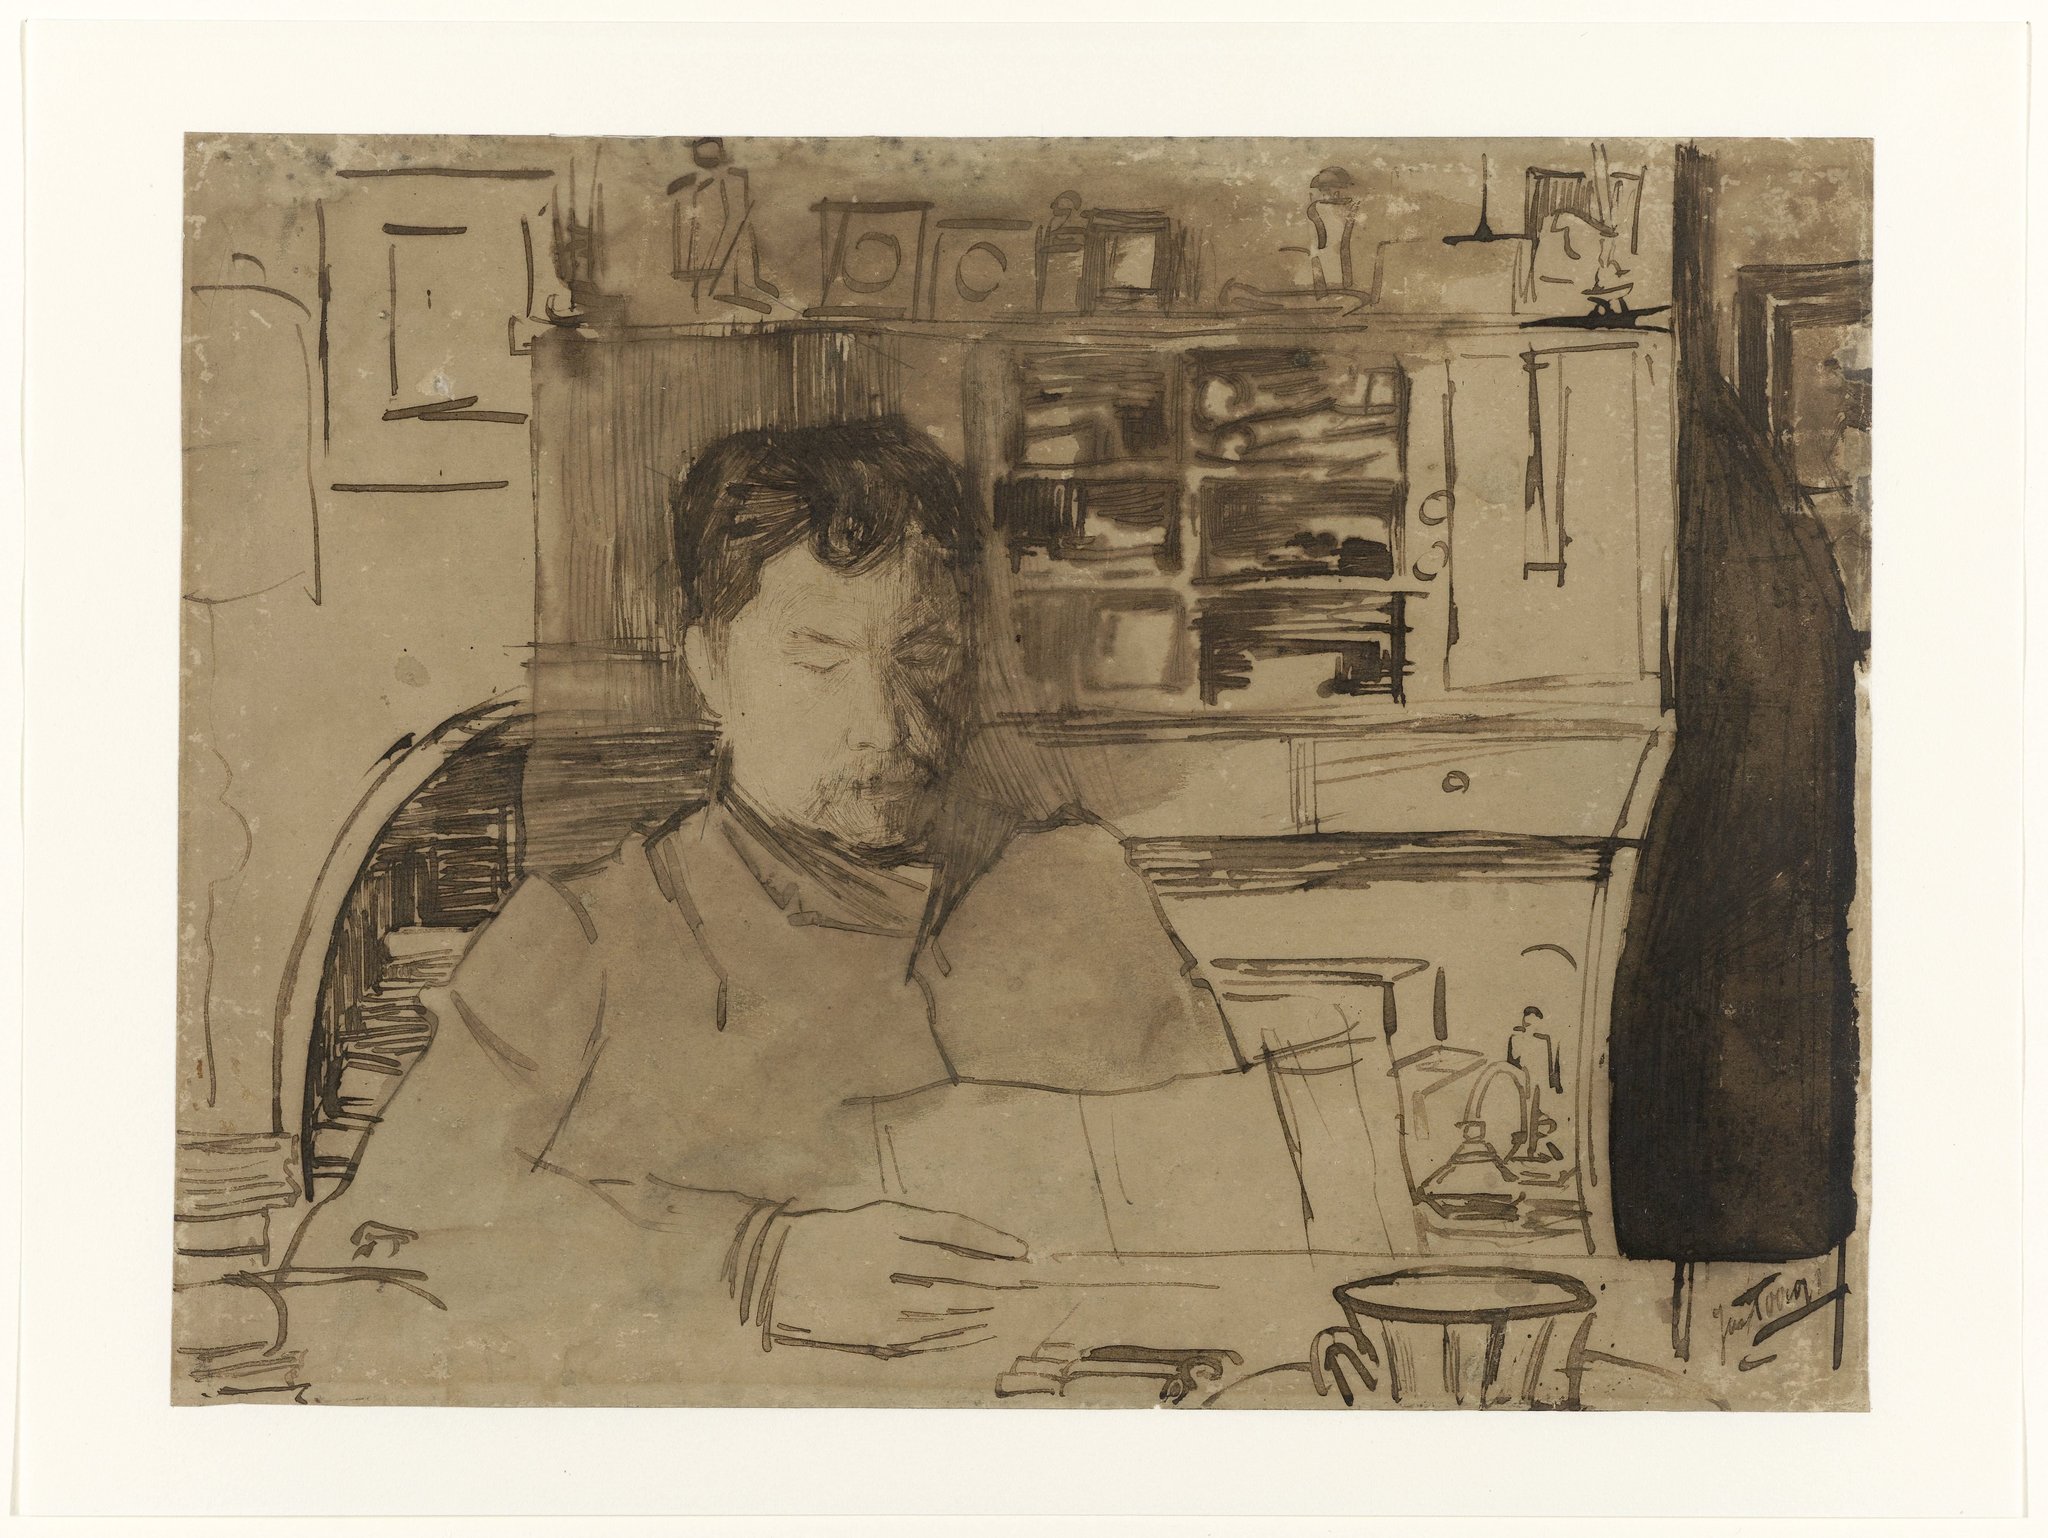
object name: drawing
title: Portret van een lezende man, zittend in een interieur aan een tafel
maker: jan toorop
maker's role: draughtsman, painter, print maker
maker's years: 1858-1928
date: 1868-1928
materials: paper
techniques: brush, pen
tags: interior of the house